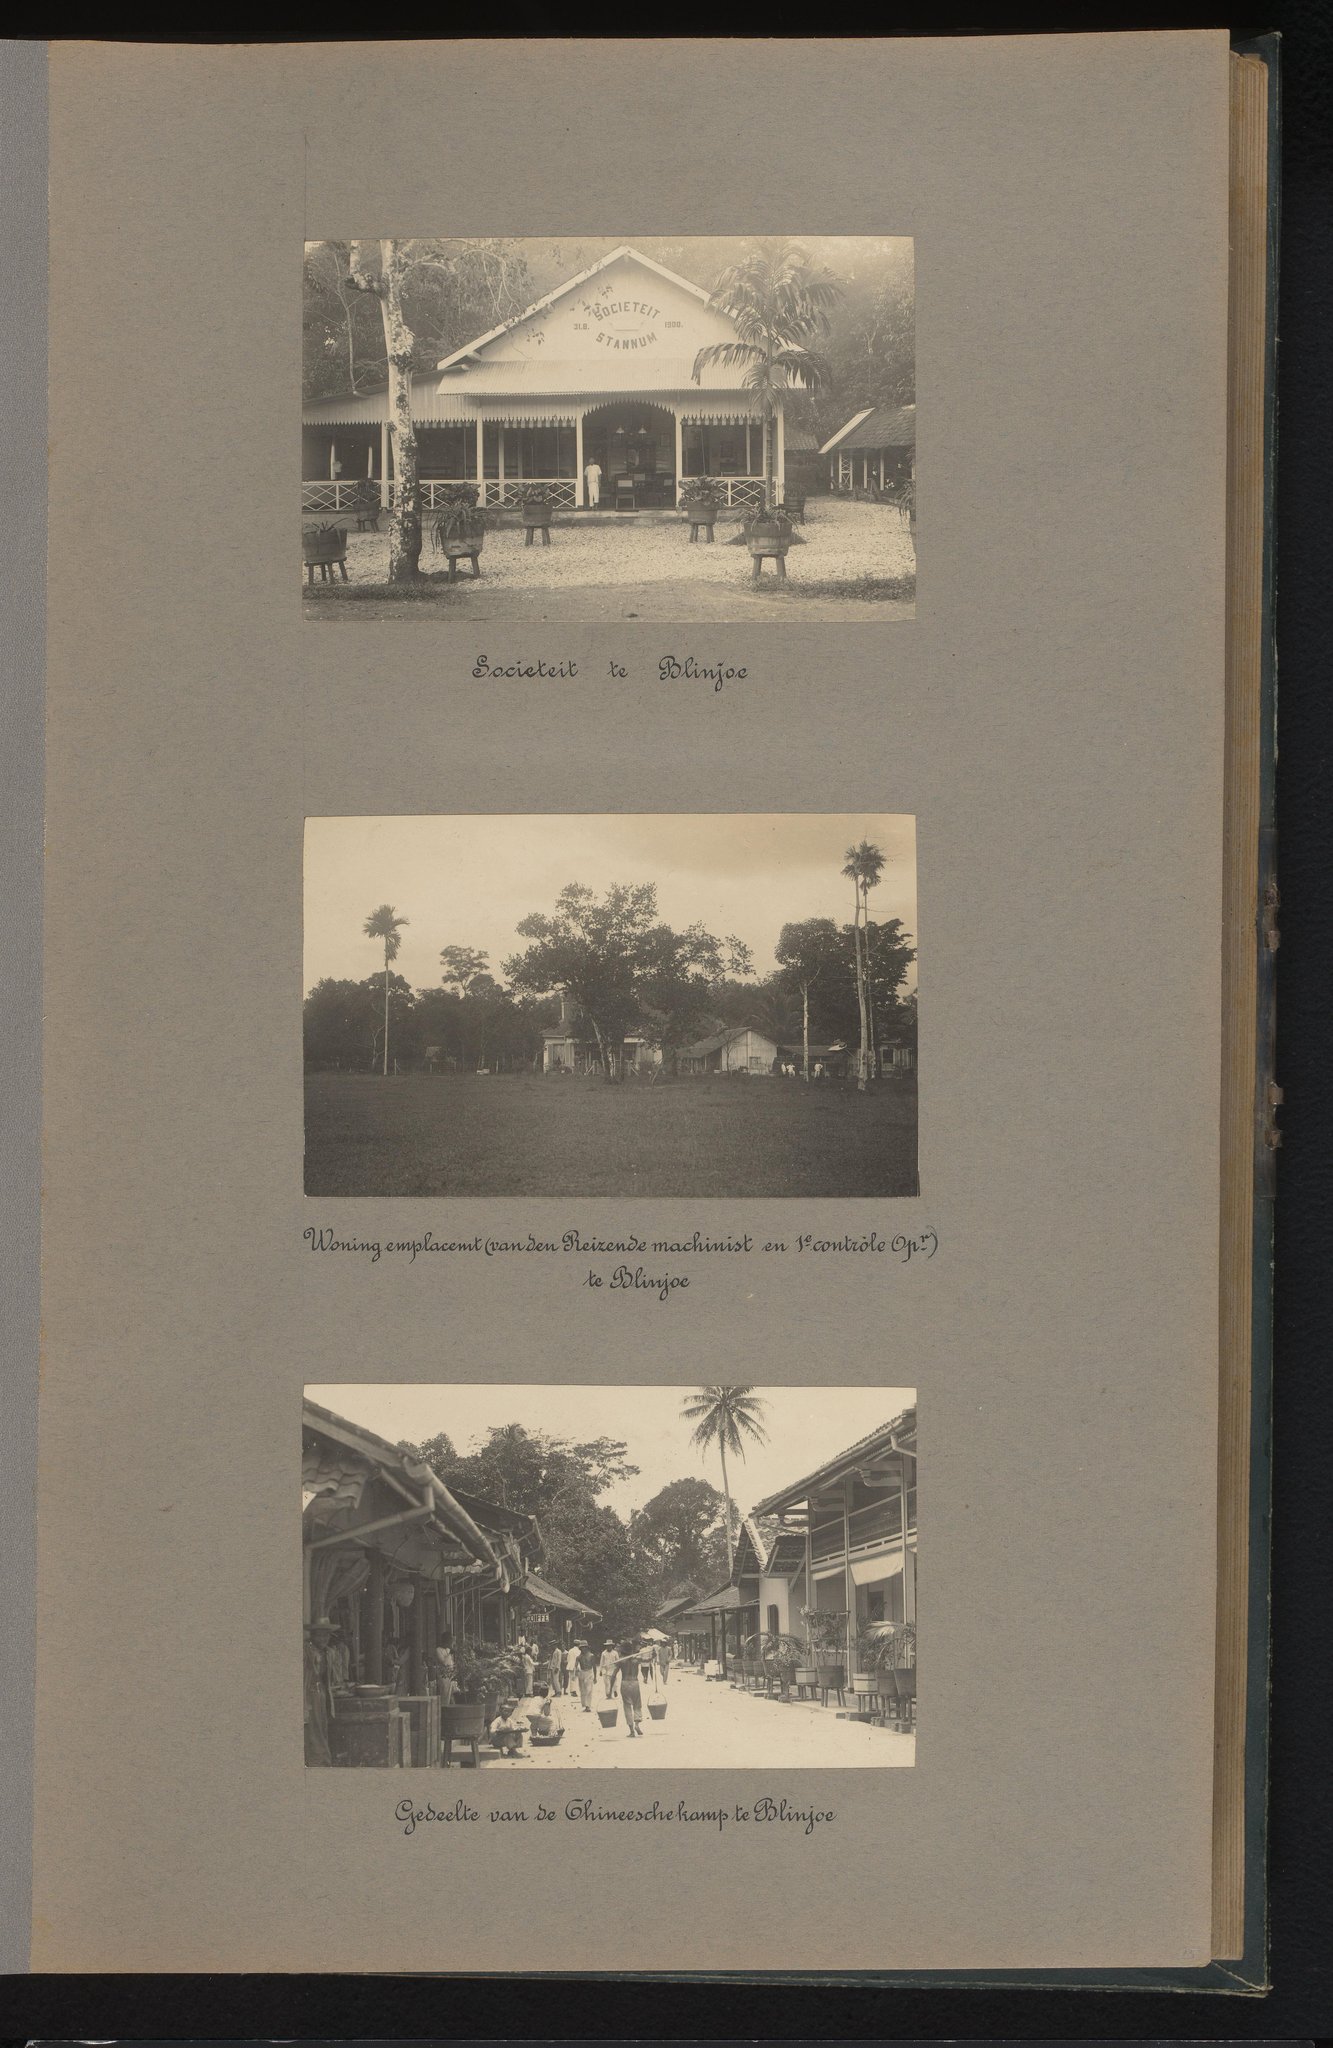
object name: photograph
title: Sociëteit, woning en Chinese kamp van de Banka-tinwinning te Blinjoe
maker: Anonymous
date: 1914-1919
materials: cardboard, photographic support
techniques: gelatin silver print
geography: bangka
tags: robert julius boers, colonial system, mining, village street, working class, labourers, villa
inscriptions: inscription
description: Albumblad met drie foto's van de sociëteit, een woning en het Chinese kamp van de Banka-tinwinning te Blinjoe. Onderdeel van het fotoalbum aangeboden aan Robert Julius Boers bij zijn vertrek naar Nederland in 1919 door het personeel van de Banka-tinwinning.